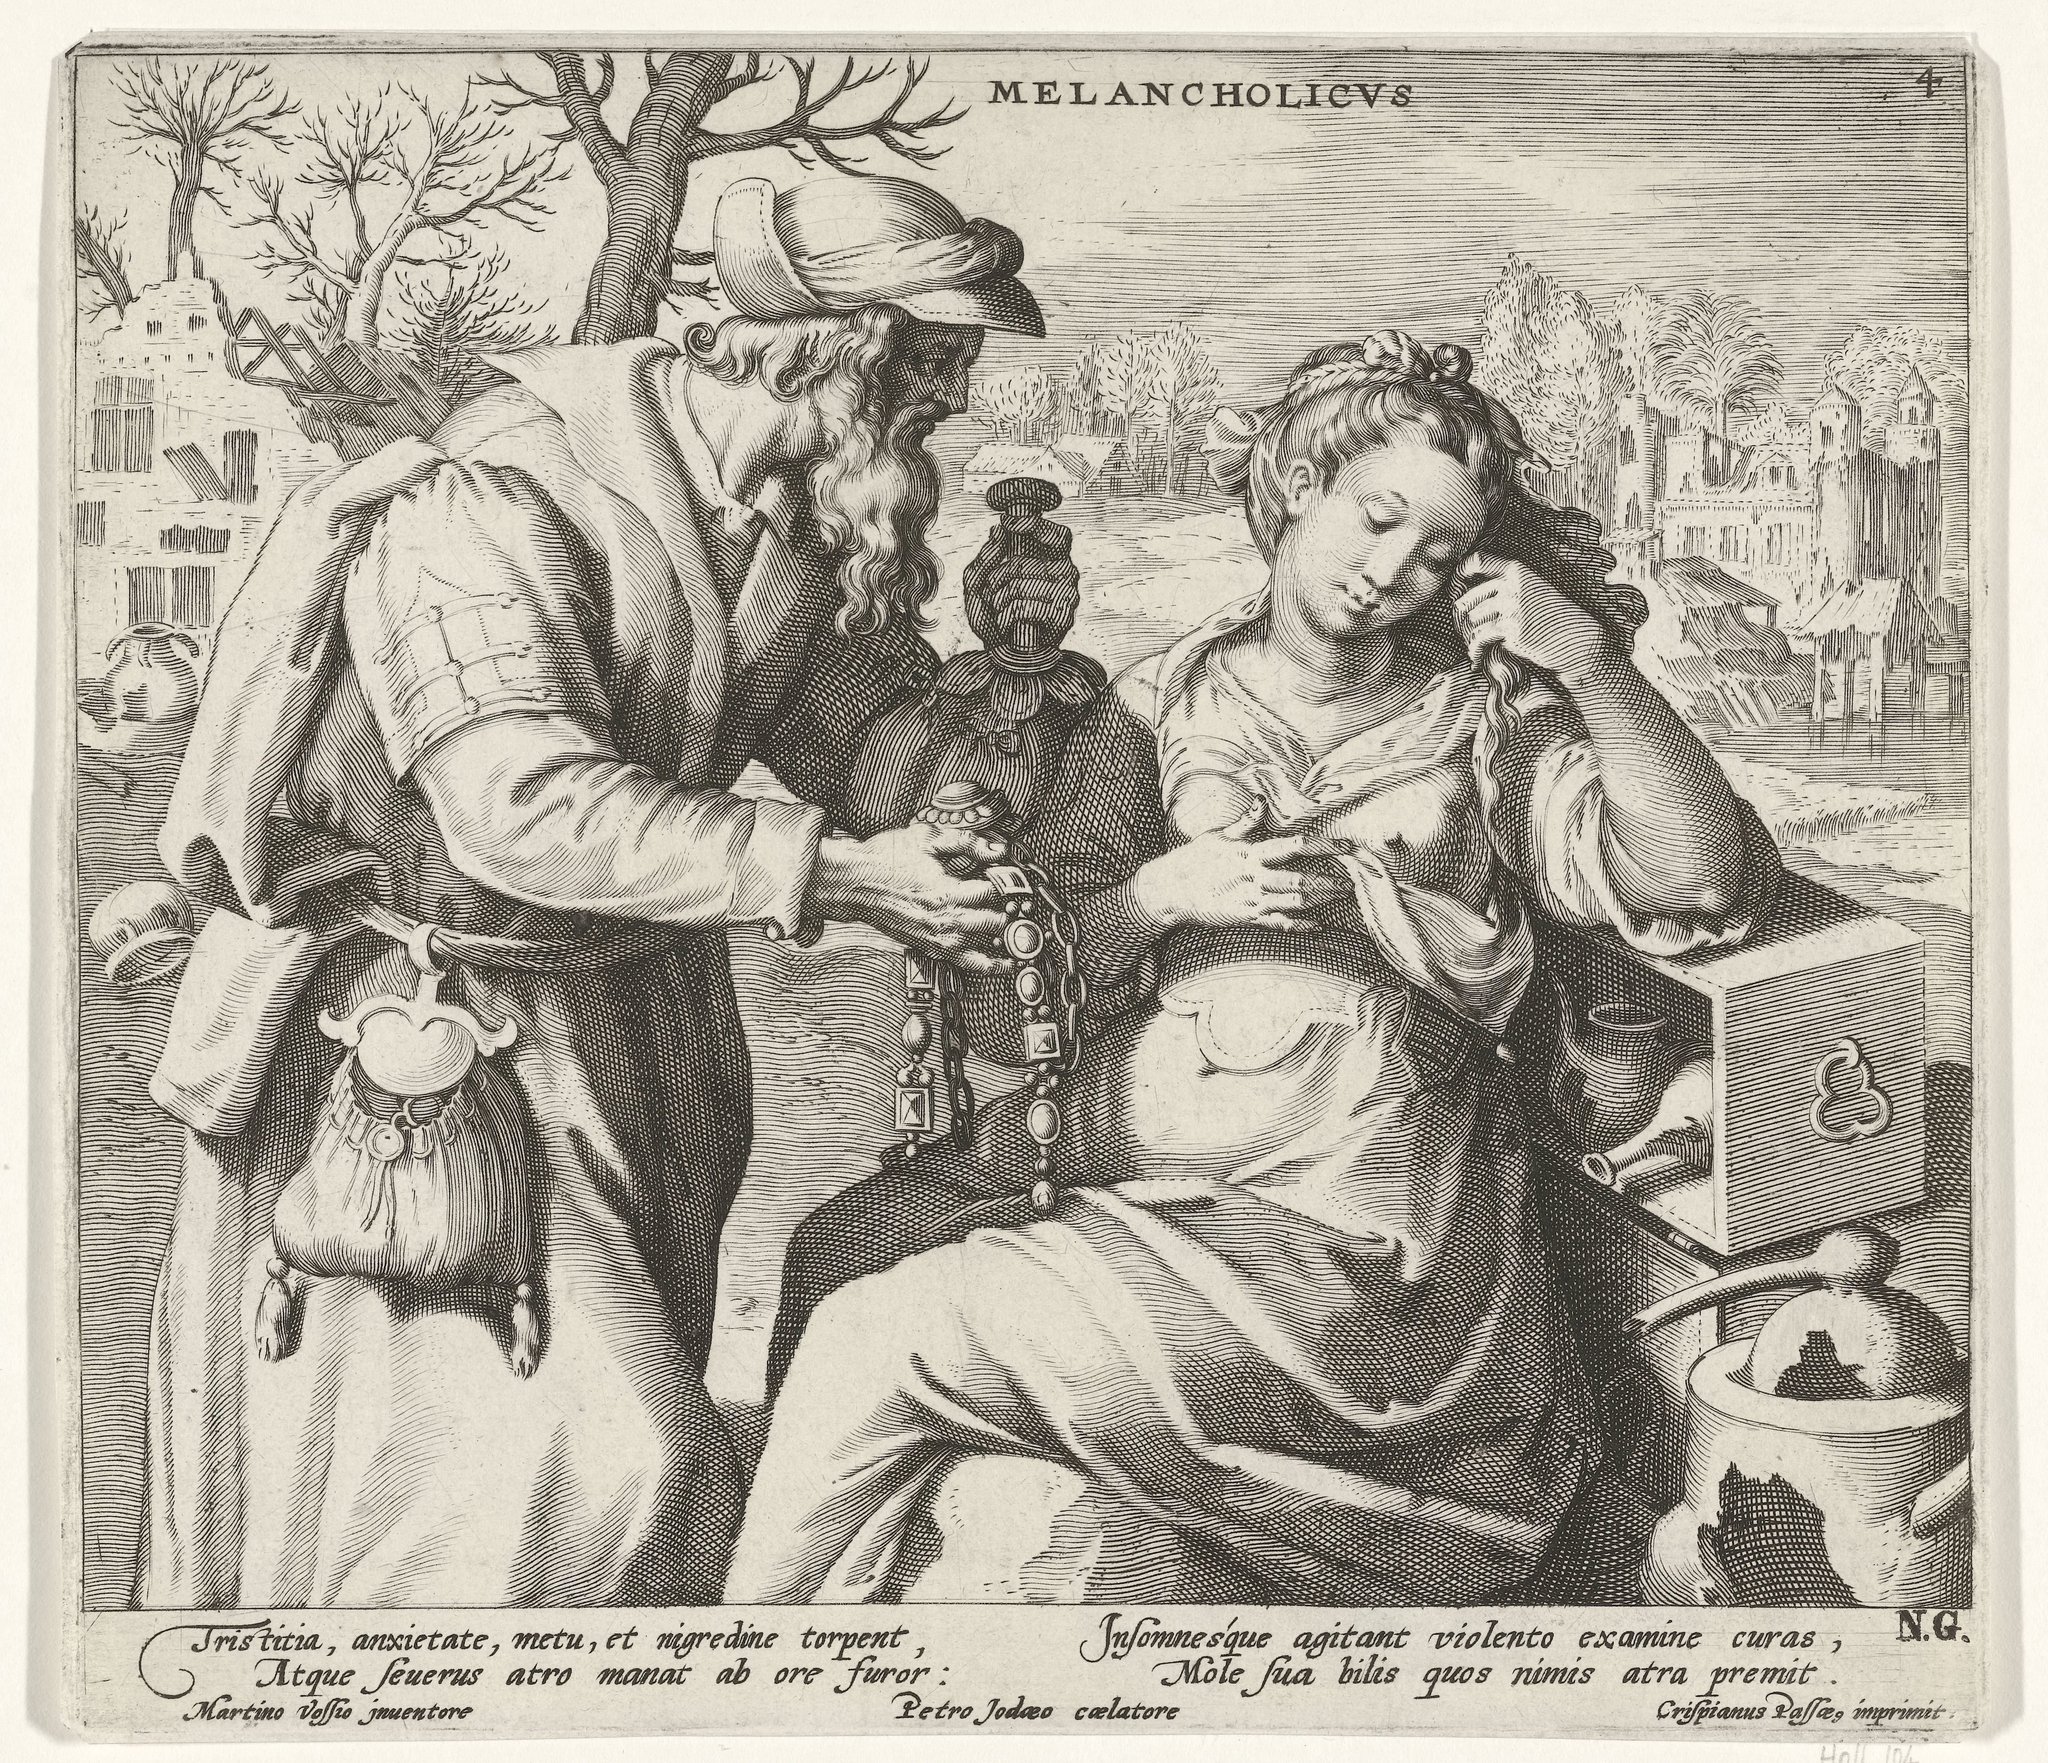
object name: print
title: De vier temperamenten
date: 1590-1632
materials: paper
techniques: engraving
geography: antwerp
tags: purse, money-bag, melancholic temperament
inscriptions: collector's mark: Lugt 1967, collector's mark: Lugt 2228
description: Landschap met een jonge vrouw, met neergeslagen ogen, leunend op een kistje. Een oude man biedt haar juwelen en een stokkenbeurs vol geld aan. In de marge, in twee kolommen, een onderschrift in het Latijn. Vierde prent uit een serie van vier met de vier temperamenten.